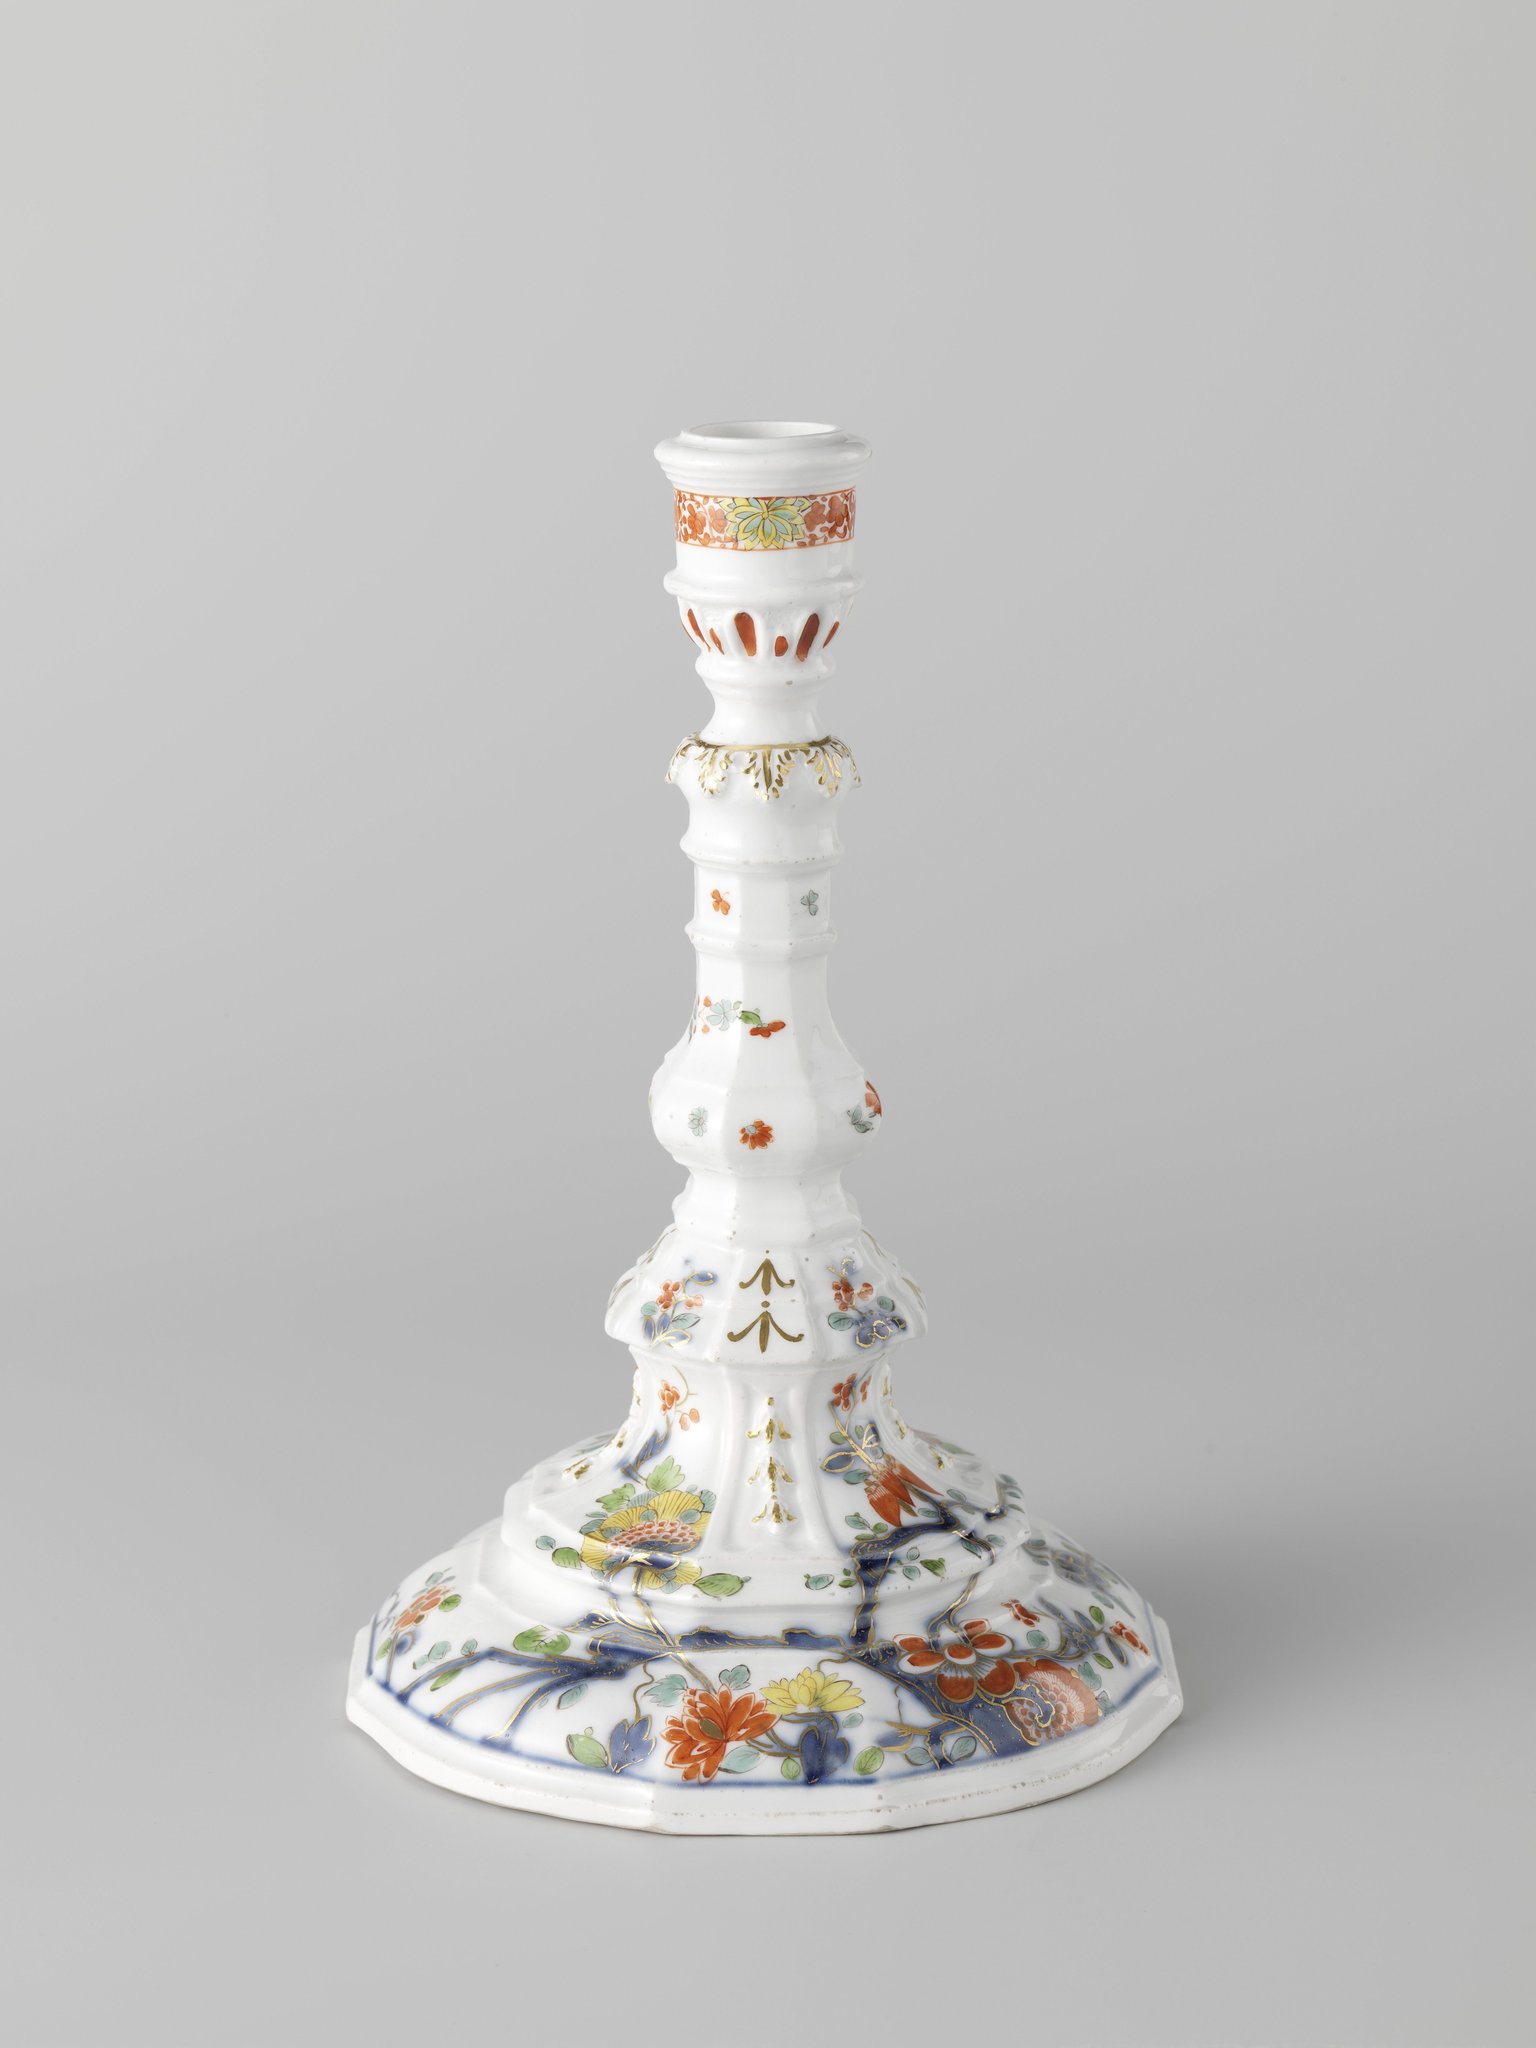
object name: candlestick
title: Kandelaar, veelkleurig beschilderd met Indianische Blumen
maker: andreas schiefer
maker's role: porseleinmodelleur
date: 1730-1735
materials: porcelain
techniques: painted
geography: meissen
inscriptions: painter's mark: ‘K’, factory mark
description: Two candlesticks. Porcelain. Meissen, c. 1730.